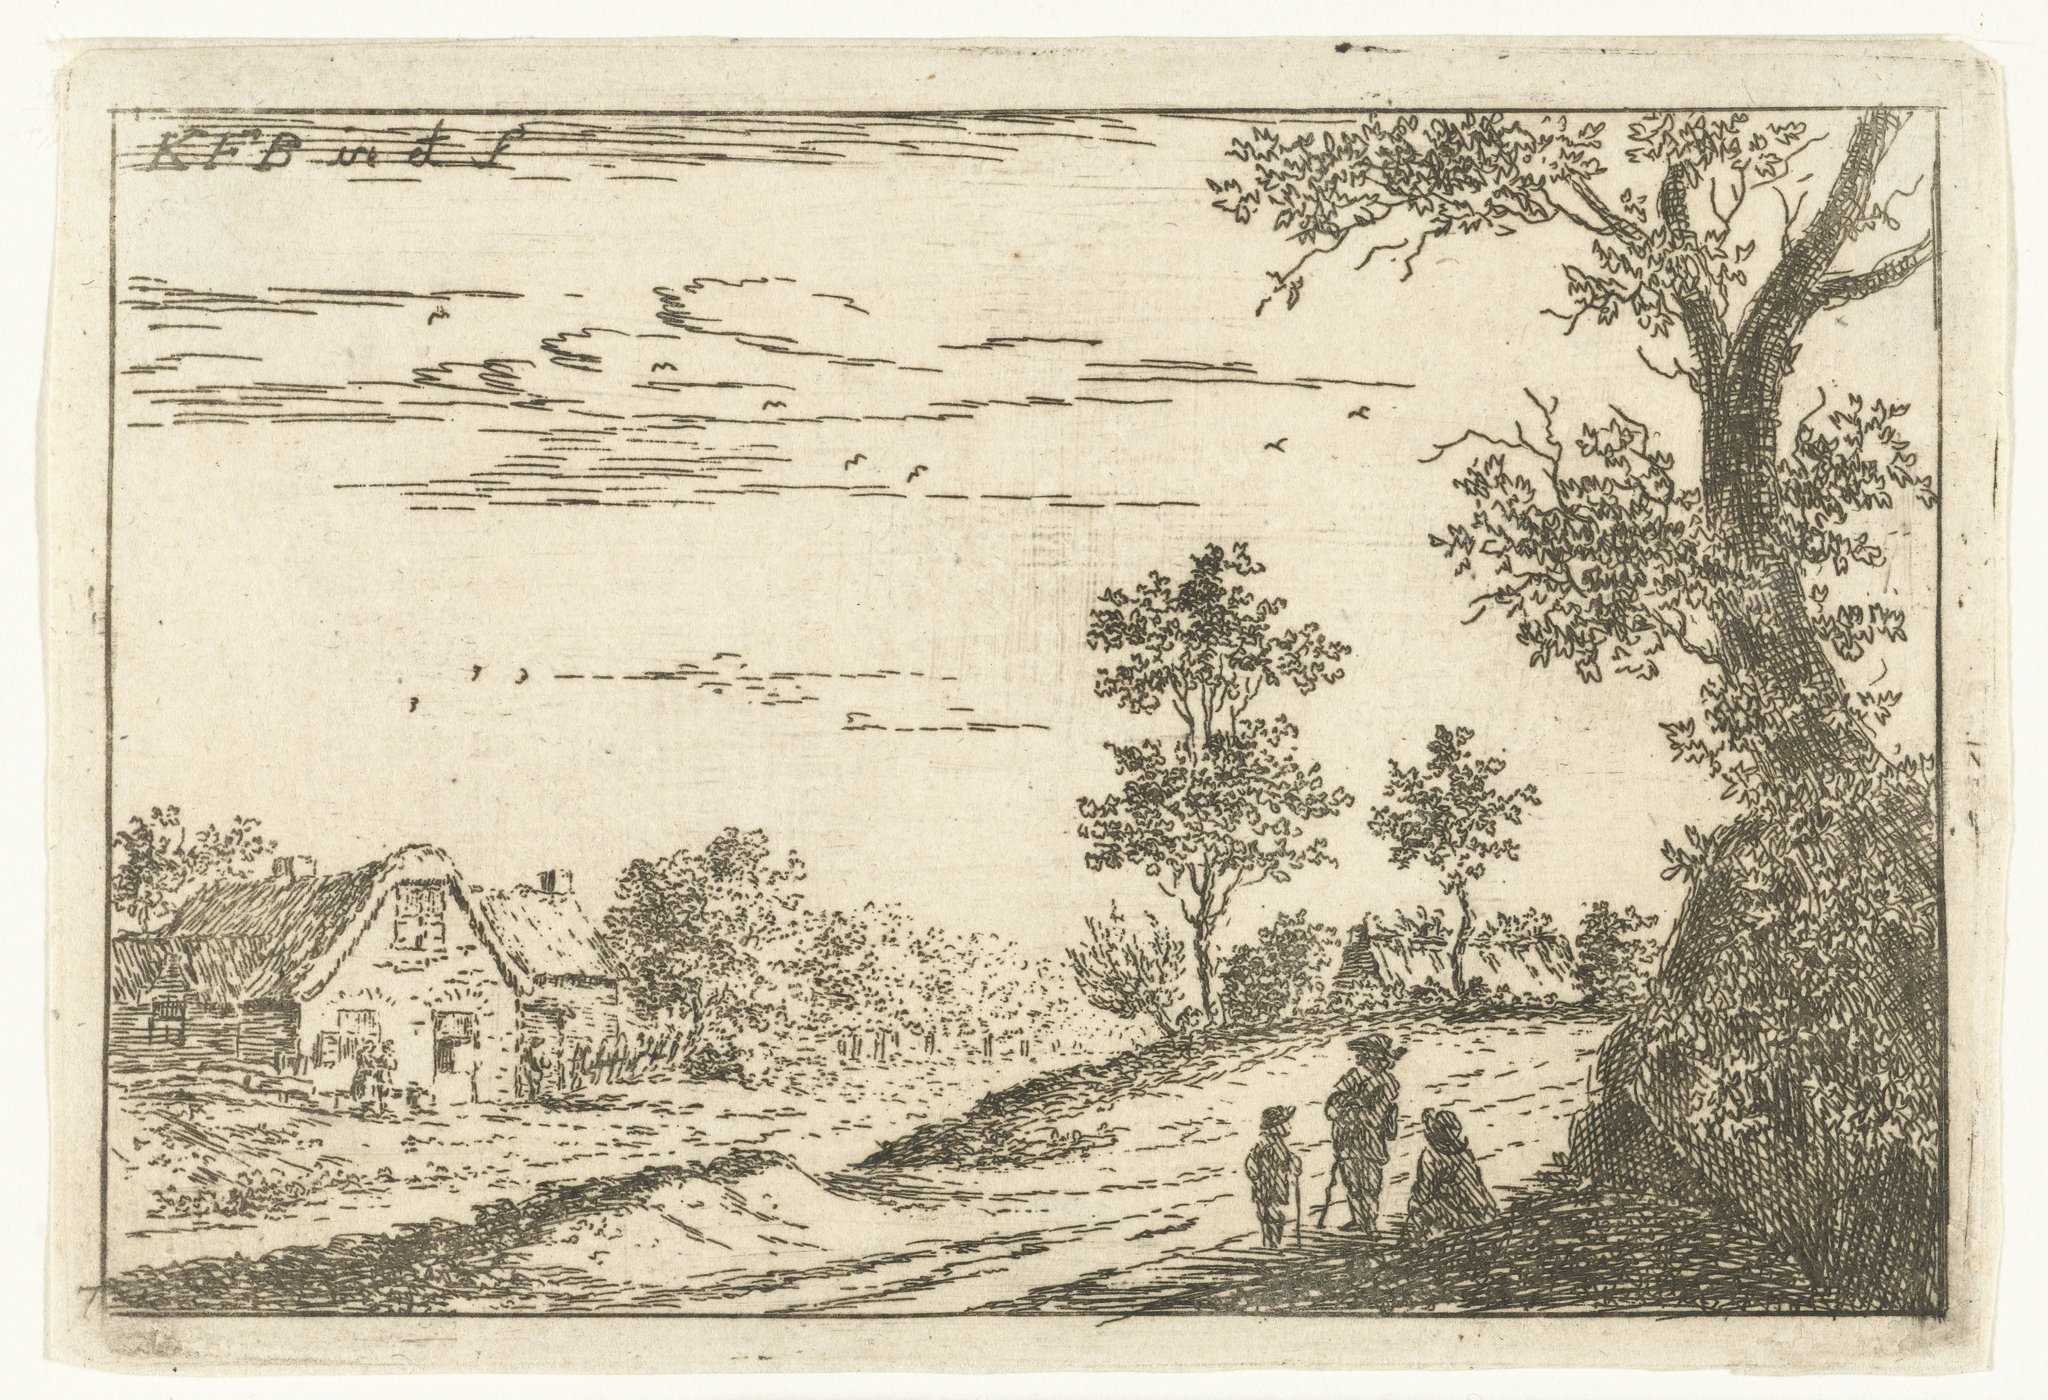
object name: print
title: Landschappen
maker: carel frederik bendorp (i)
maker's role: print maker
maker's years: 1736-1814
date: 1769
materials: paper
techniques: etching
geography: rotterdam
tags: farm or solitary house in landscape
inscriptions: collector's mark: Lugt 2228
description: Prent uit serie prenten met elf landschappen.